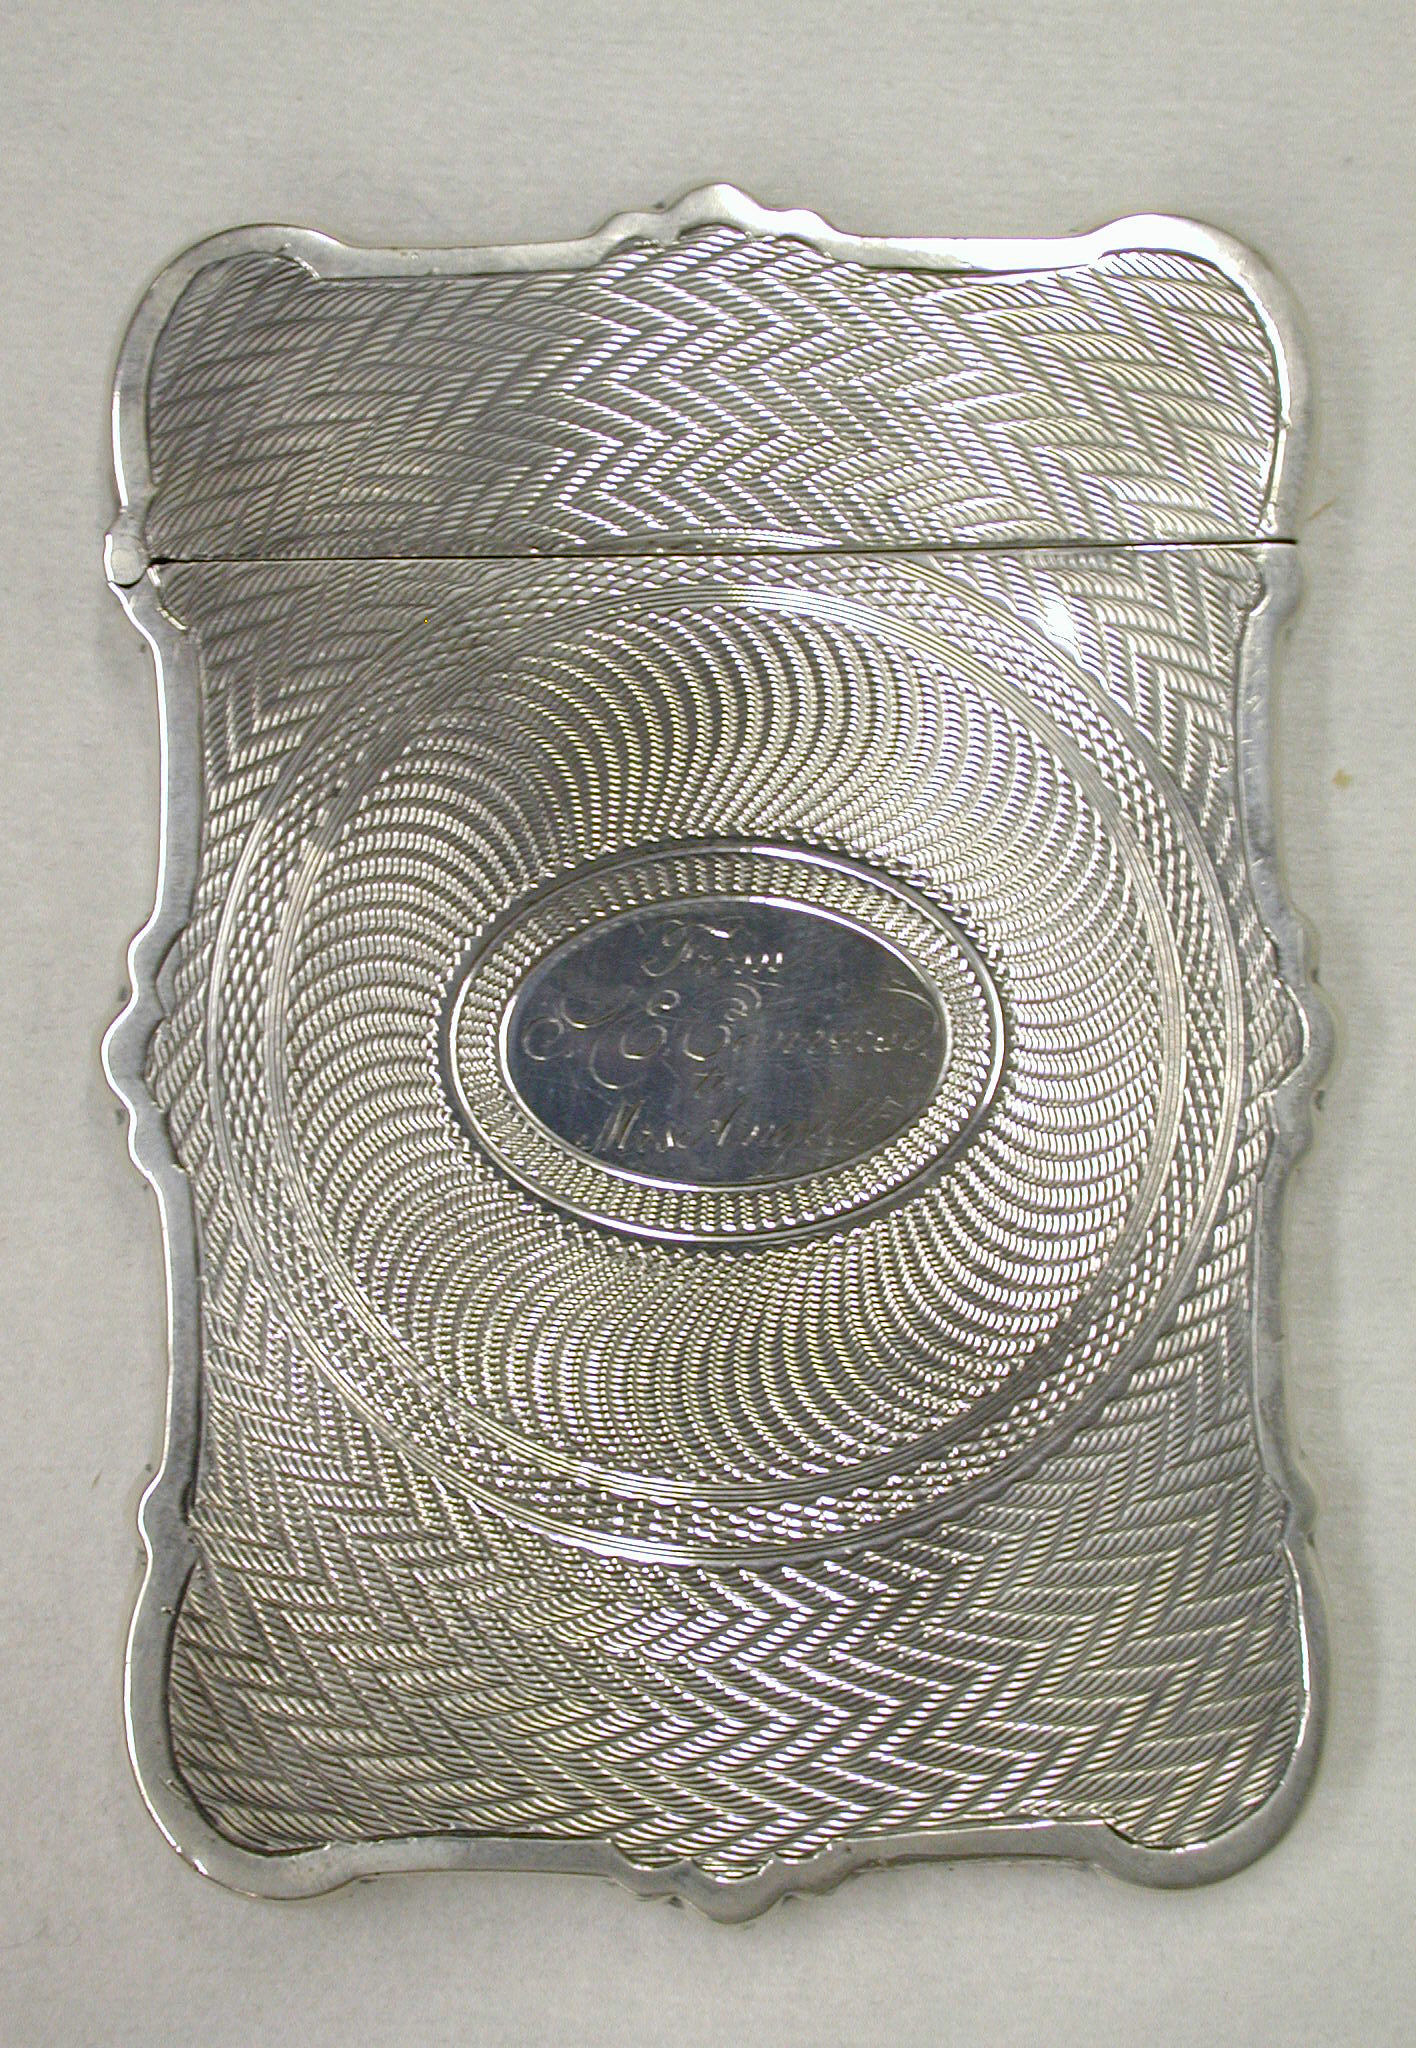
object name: card case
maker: albert coles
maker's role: maker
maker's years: 1810-1885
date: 1840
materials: silver